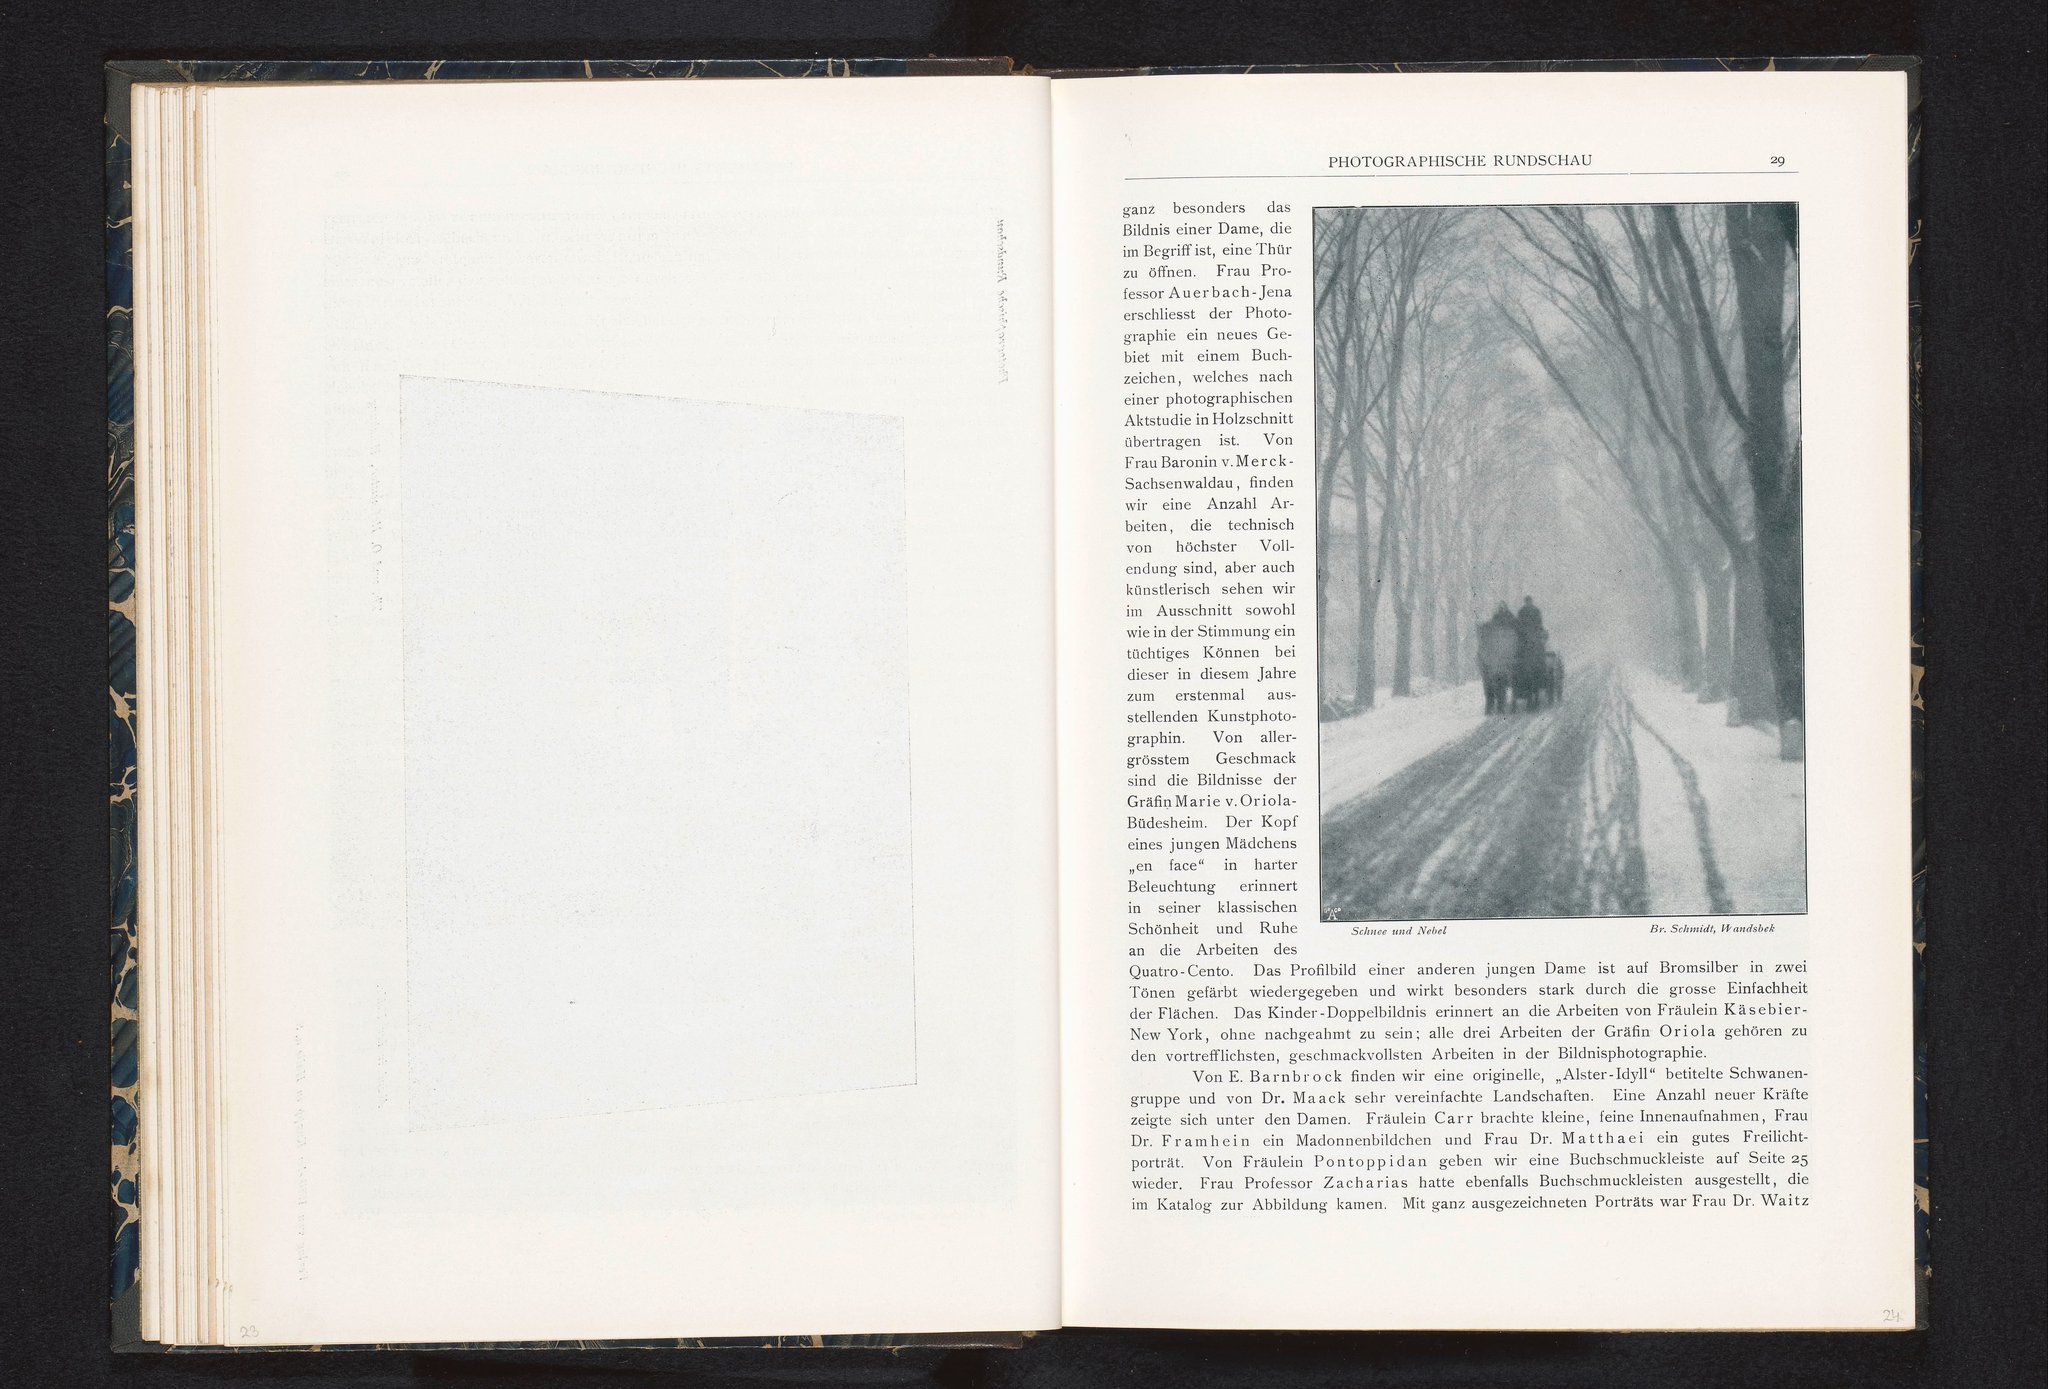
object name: page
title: Schnee und Nebel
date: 1896-1901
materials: paper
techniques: autotype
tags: road, path, snow, four-wheeled vehicle drawn by two animals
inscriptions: monogram: ‘Dr A Co’